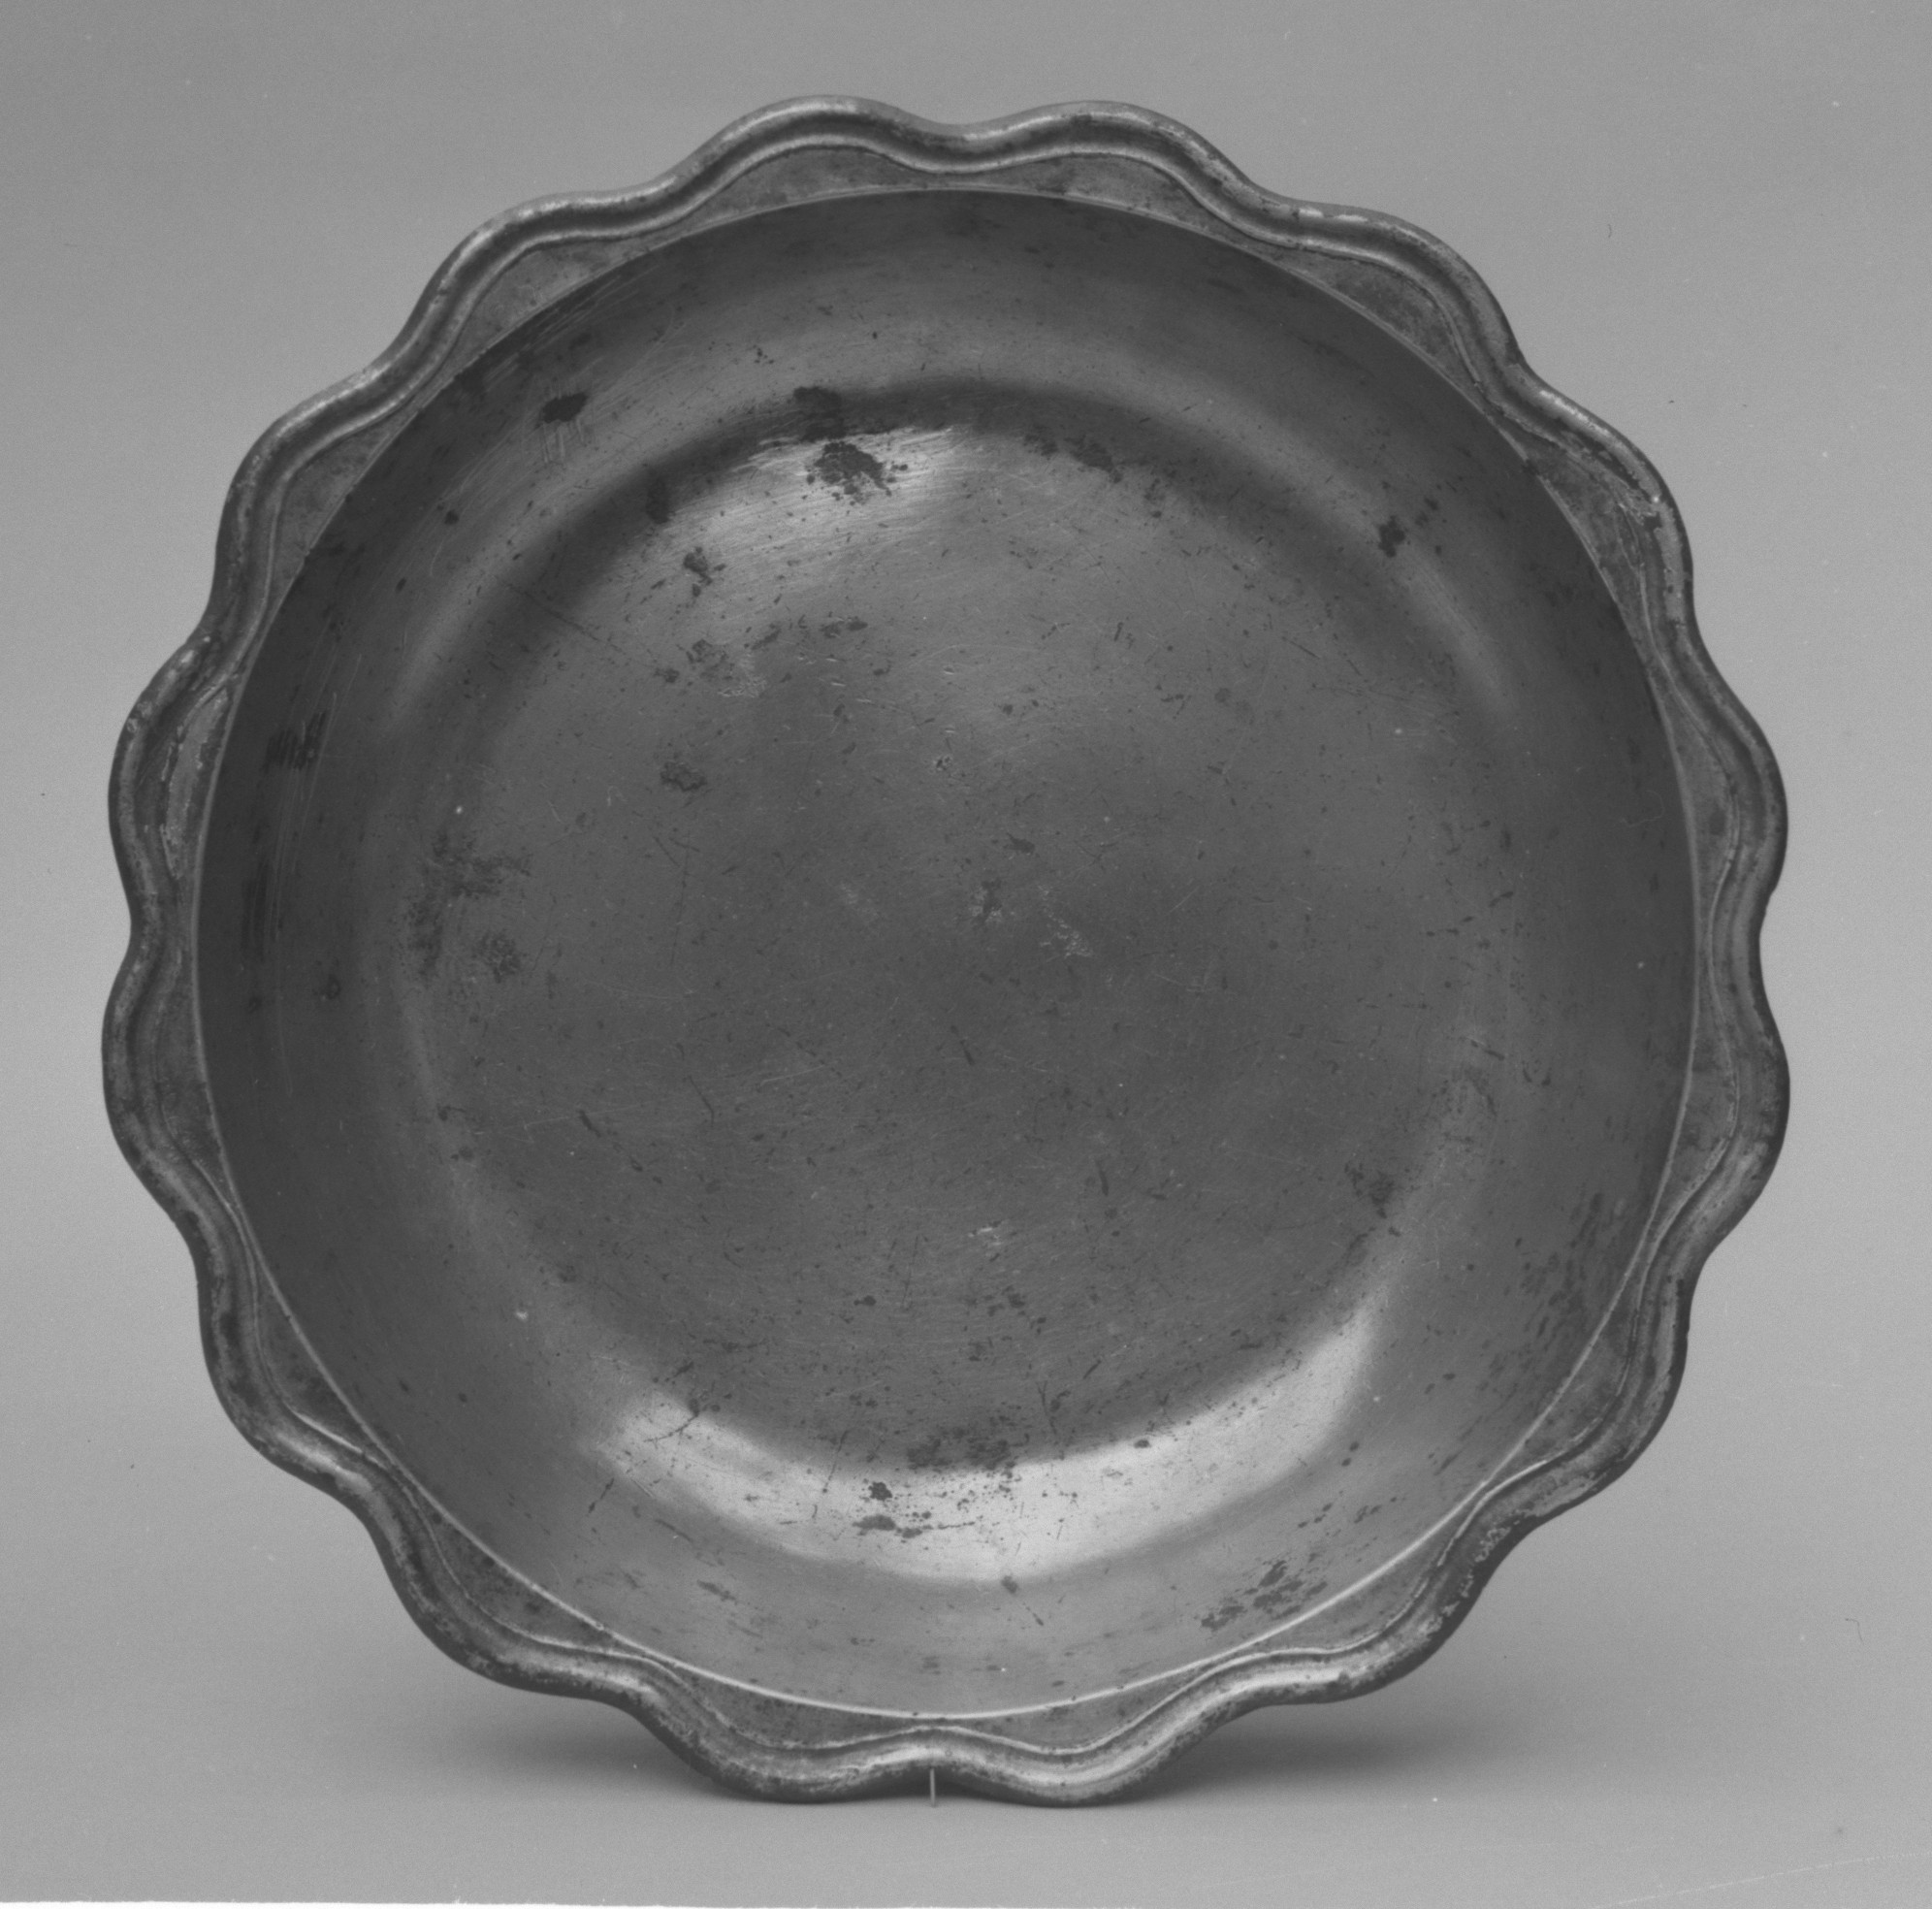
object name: dish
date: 1701-1800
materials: pewter